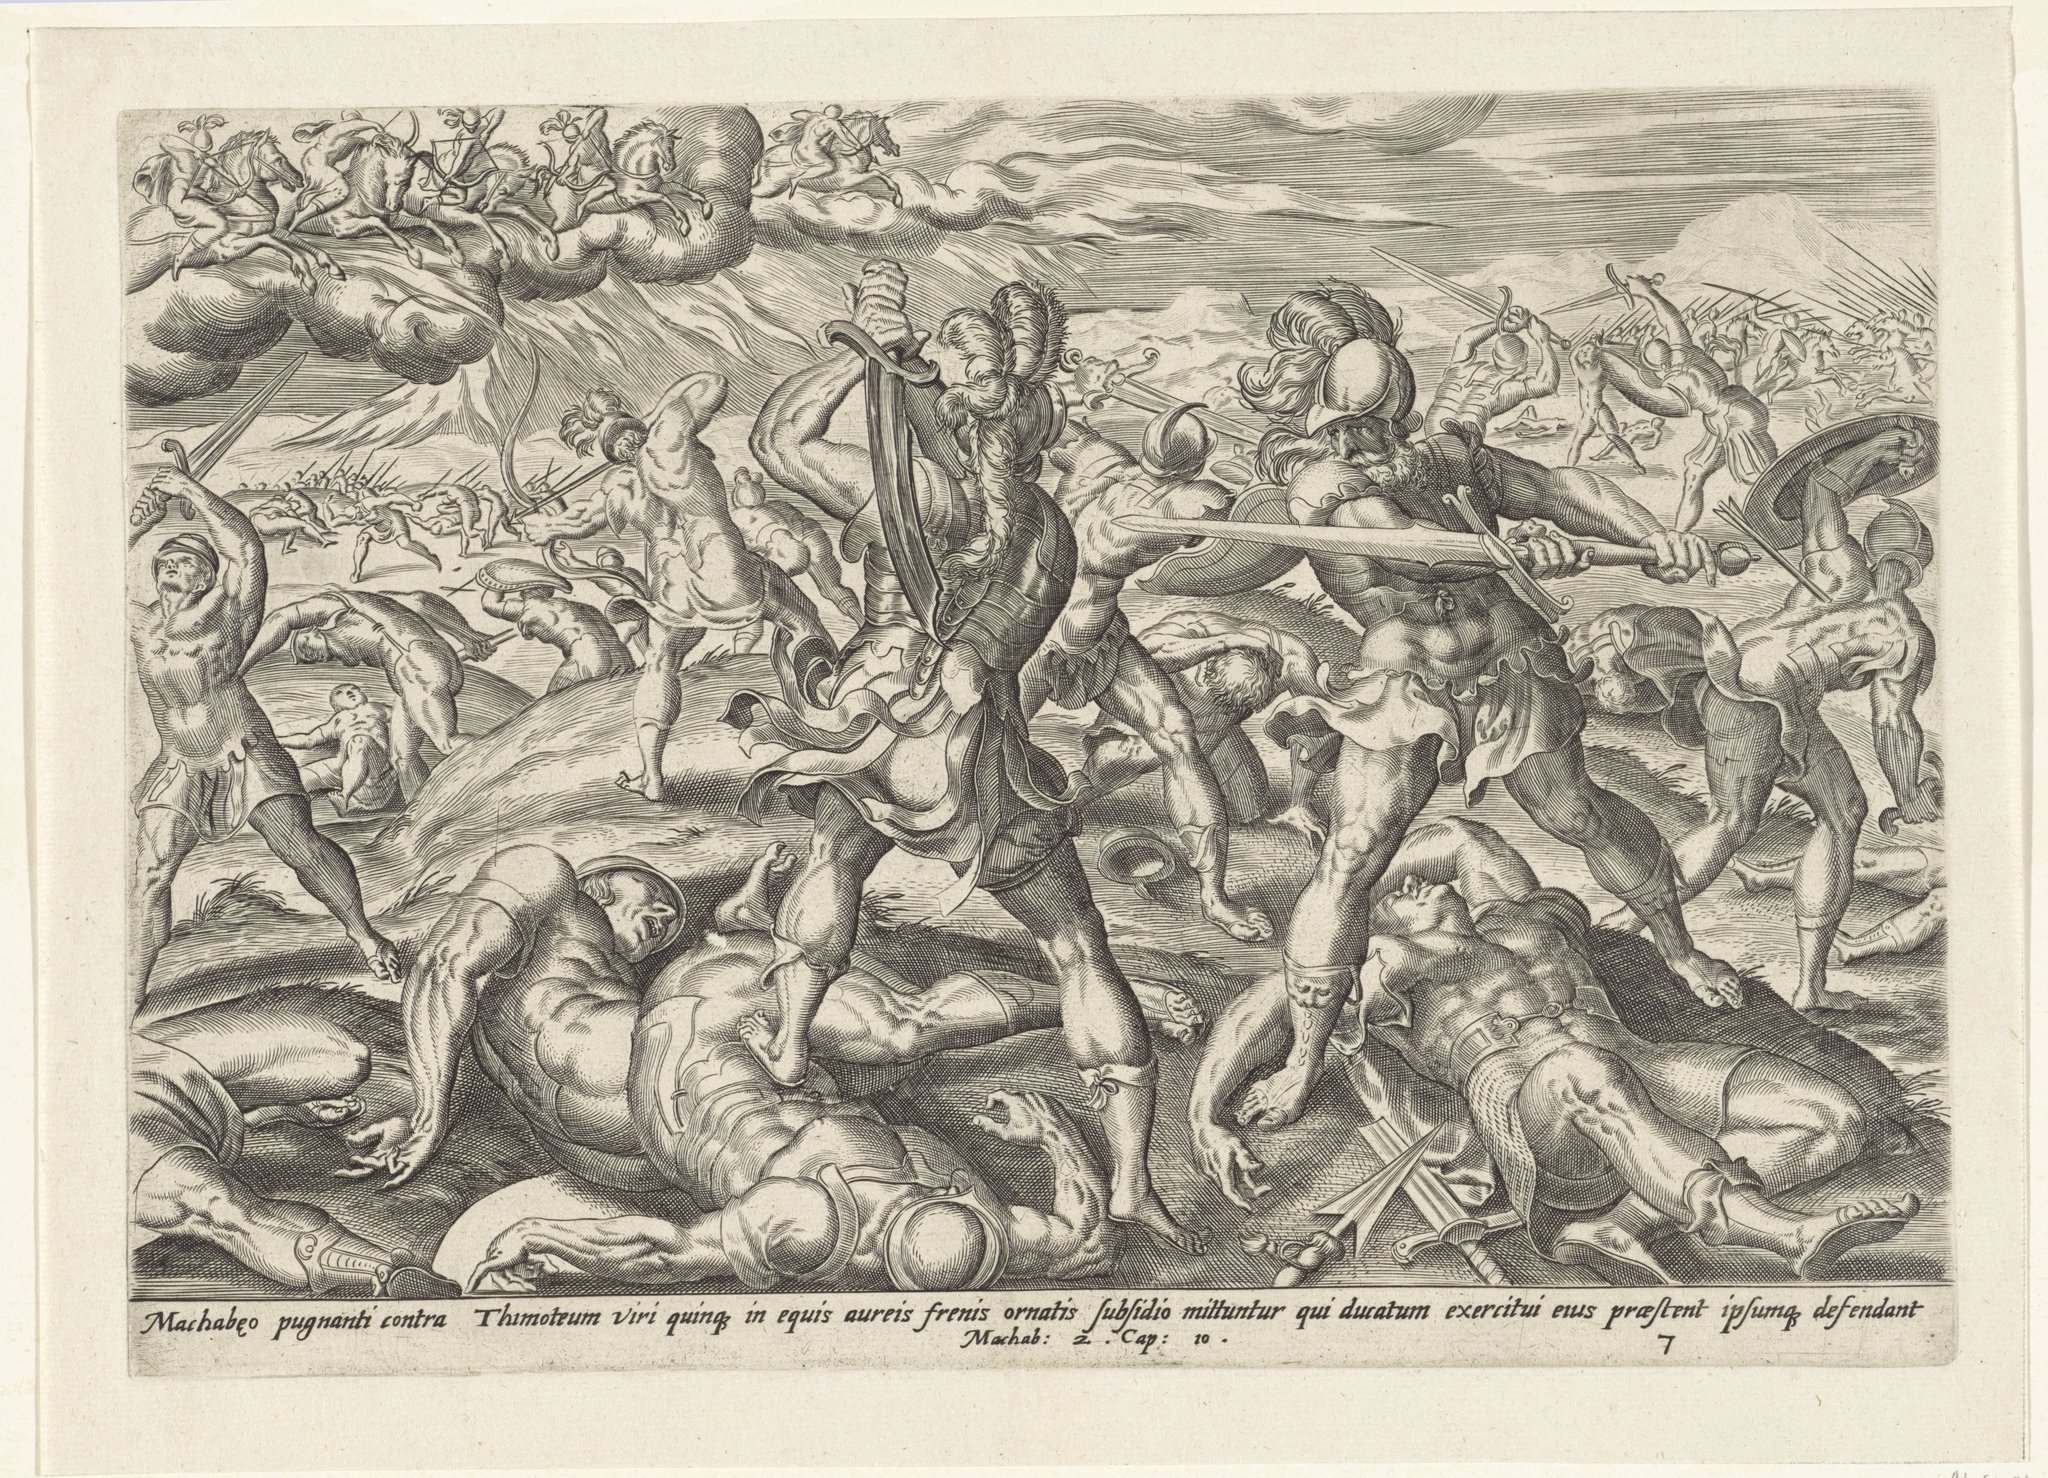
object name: print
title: Geschiedenis van de Makkabeeën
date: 1579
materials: paper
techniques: engraving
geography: antwerp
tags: riders are seen in the sky above the city of jerusalem (2 maccabees 5:2)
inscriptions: collector's mark: Lugt 2228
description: Het leger van Timoteüs trekt op tegen Judea en vecht tegen de Joden. Aan de hemel verschijnen vijf ruiters op paarden met gouden teugels, die zich aan het hoofd stellen van de Joodse troepen. Ze bestoken de mannen van Timoteüs met pijlen en bliksems. Onder de voorstelling een verwijzing in het Latijn naar de Bijbeltekst in 2 Makk. 10.